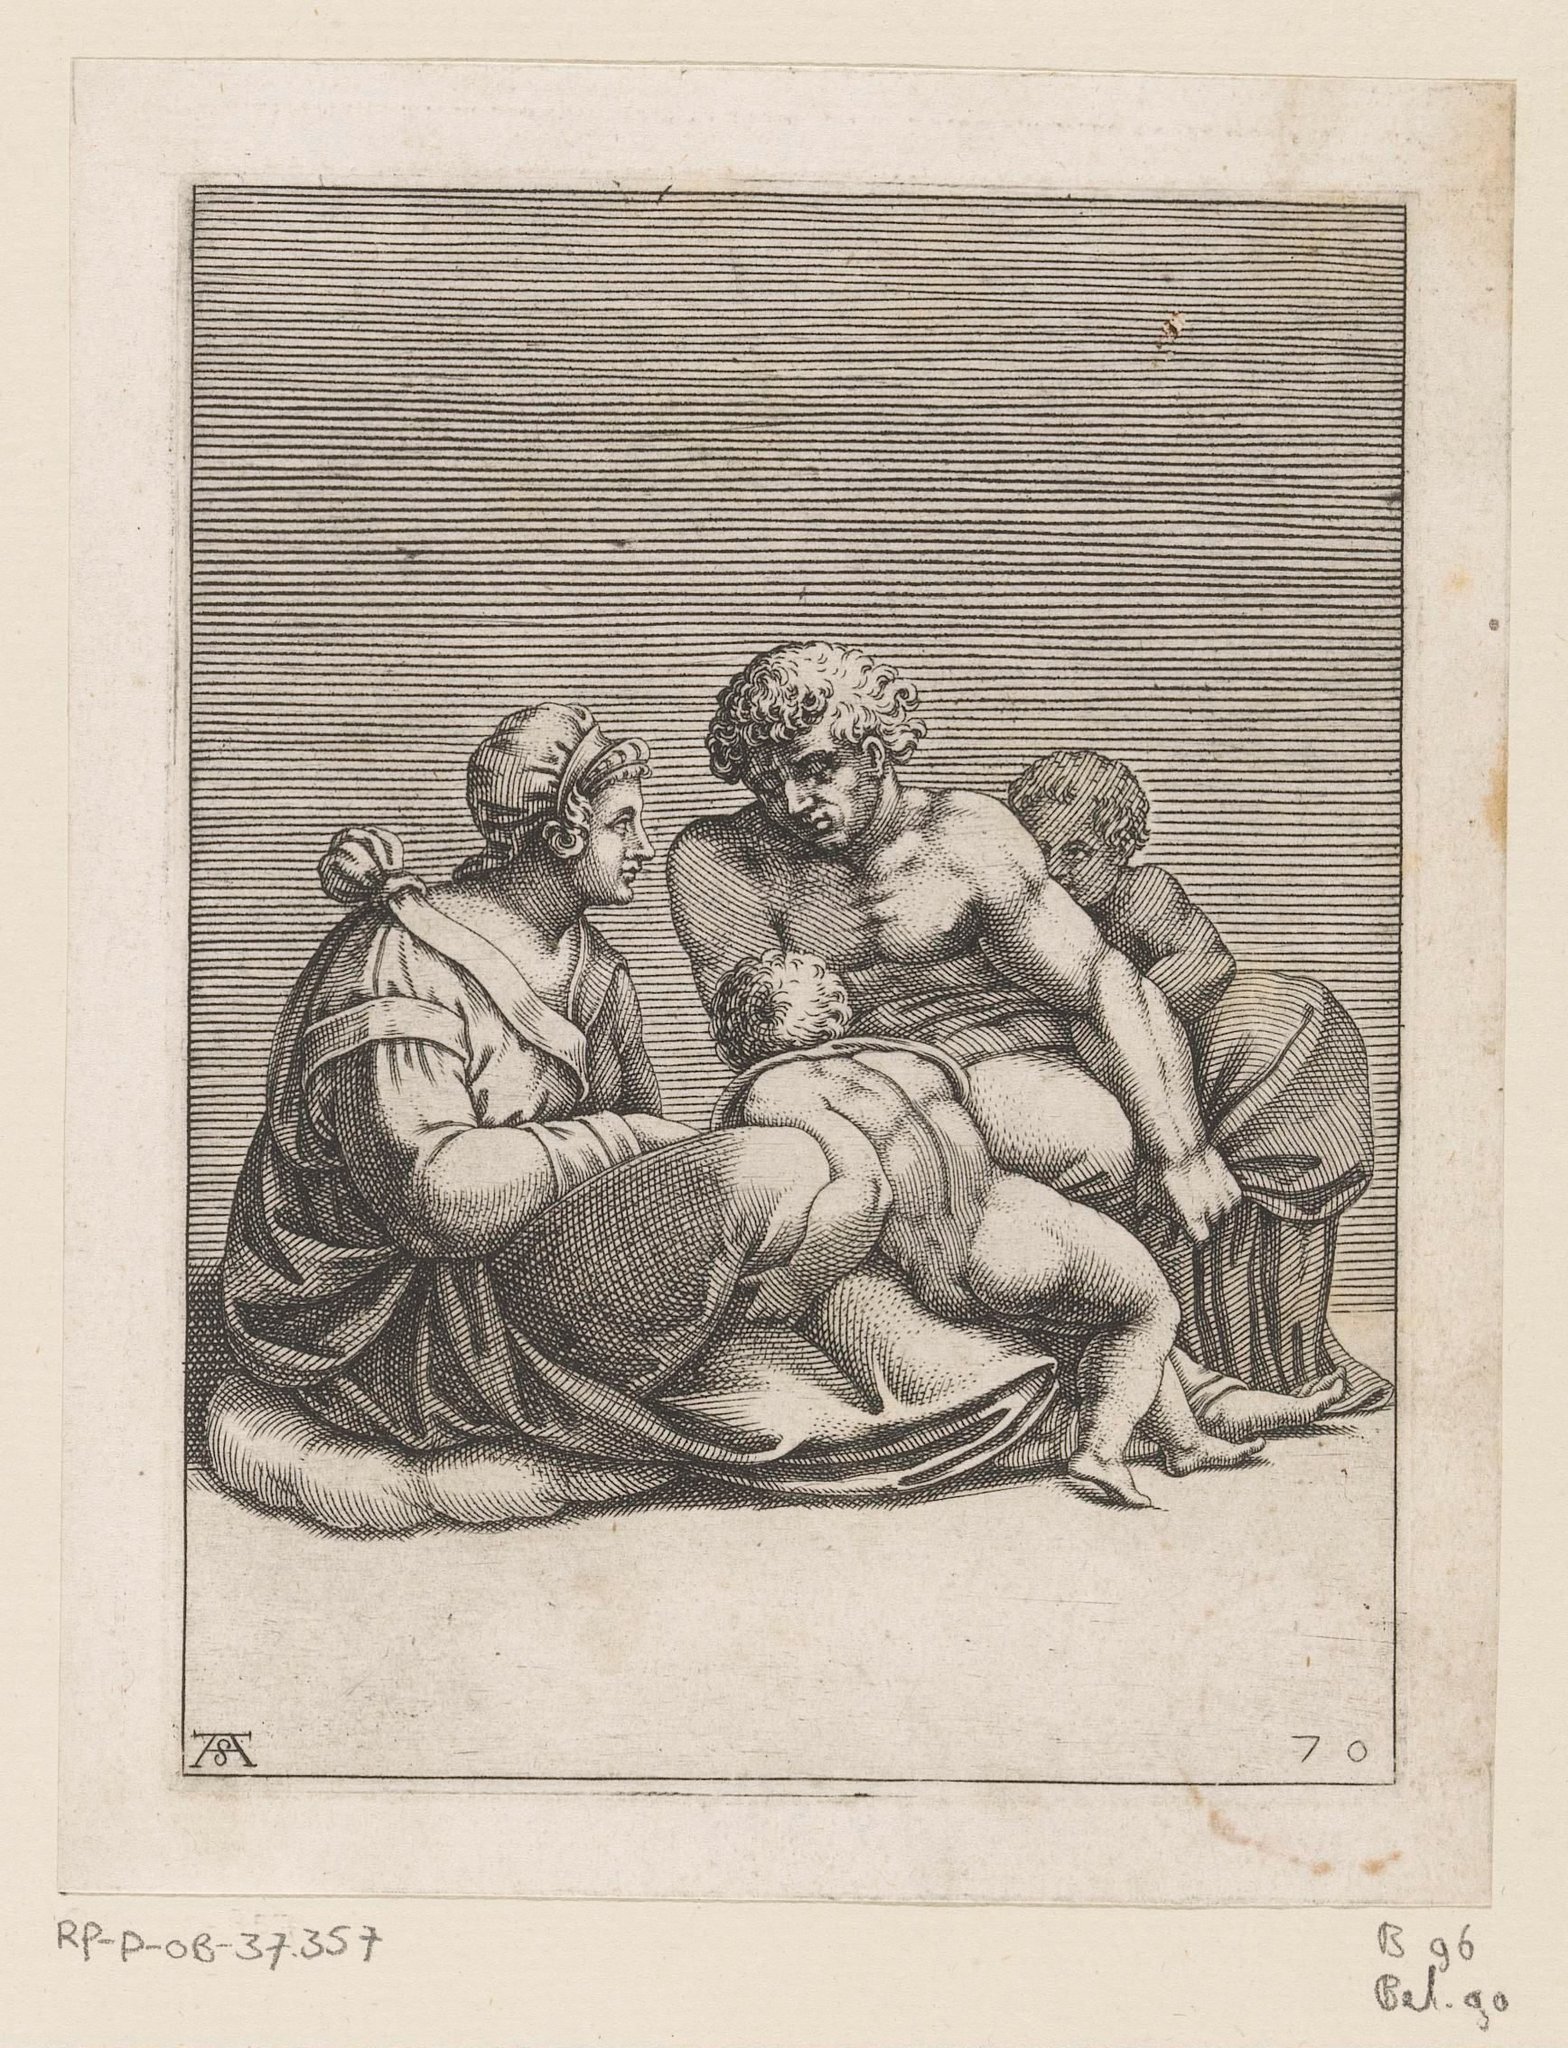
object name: print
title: Schilderingen in de Sixtijnse kapel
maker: adamo scultori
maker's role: painter, print maker, sculptor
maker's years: 1530-1585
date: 1585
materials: paper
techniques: engraving, intaglio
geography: vatican city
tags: sitting on the ground, mother and child(ren), woman and child(ren) (family group), father and child(ren), man and child(ren) (family group)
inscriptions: collector's mark: Lugt 240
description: Deze prent maakt deel uit van een serie bestaande uit een titelprent en 72 prenten naar schilderingen door Michelangelo in de Sixtijnse Kapel in het Vaticaan.